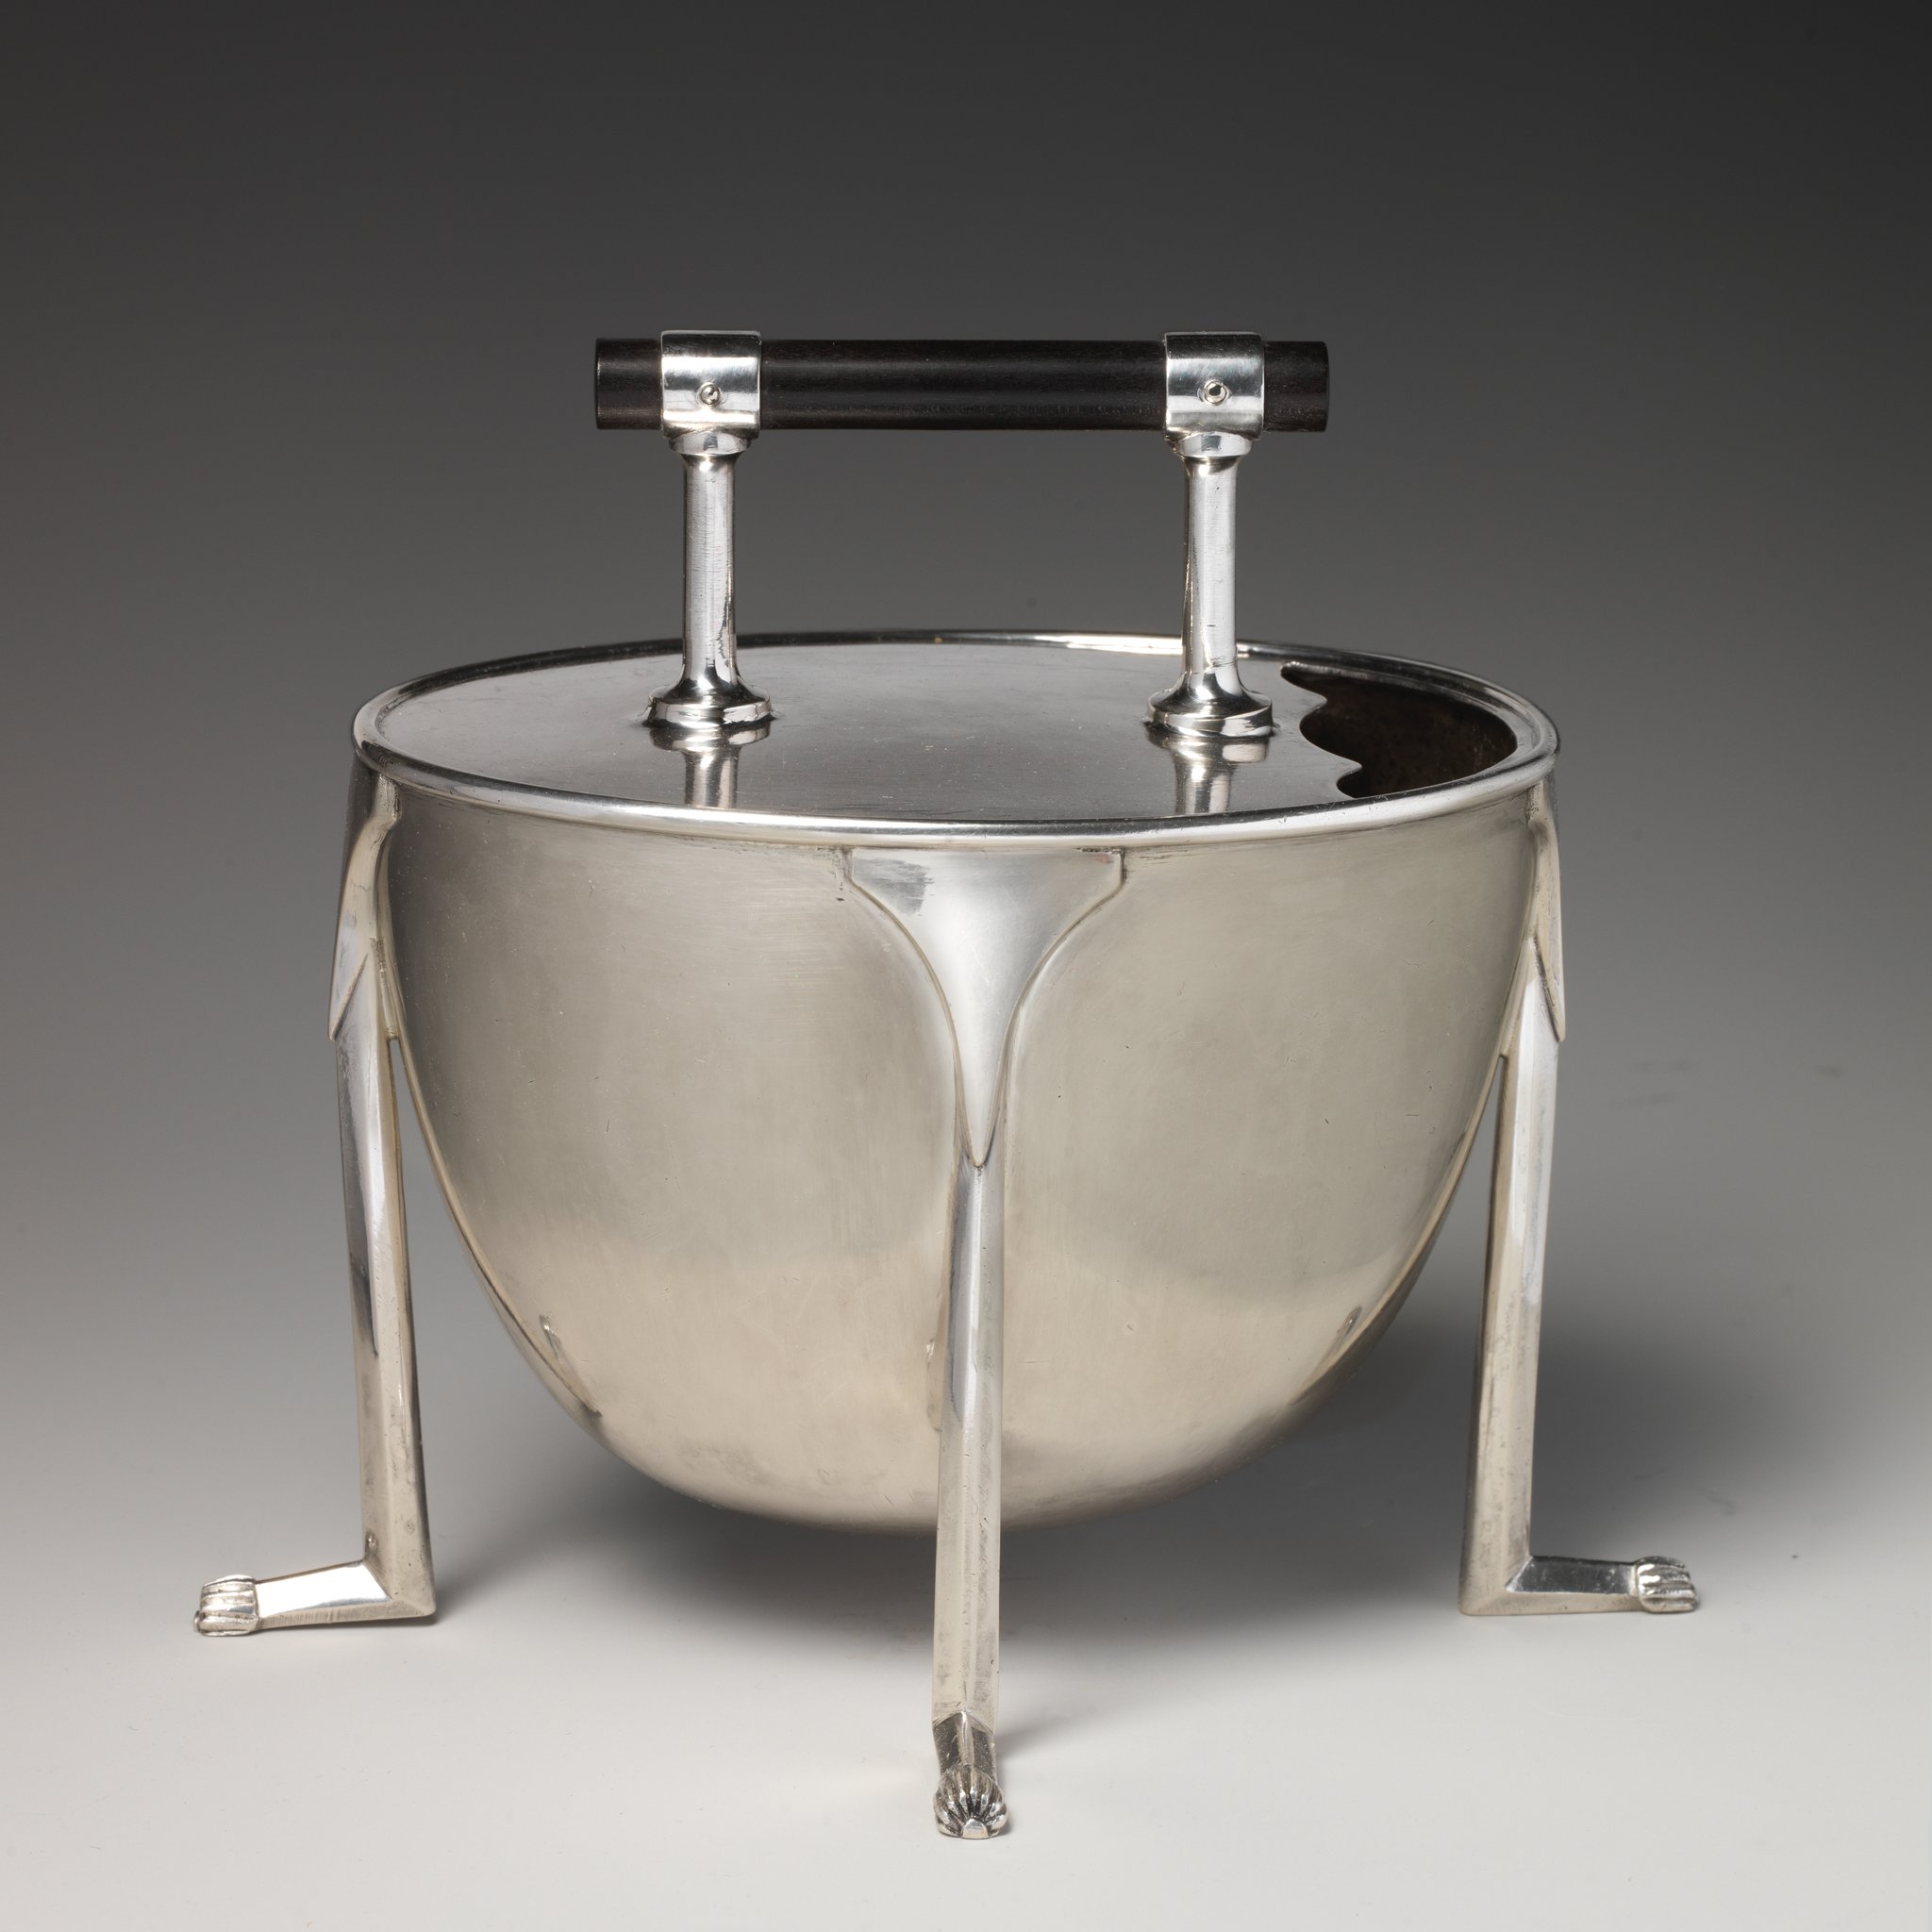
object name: spoon holder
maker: christopher dresser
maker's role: designer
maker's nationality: british, scottish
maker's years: 1834-1904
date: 1878-1881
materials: brass, wood, silver